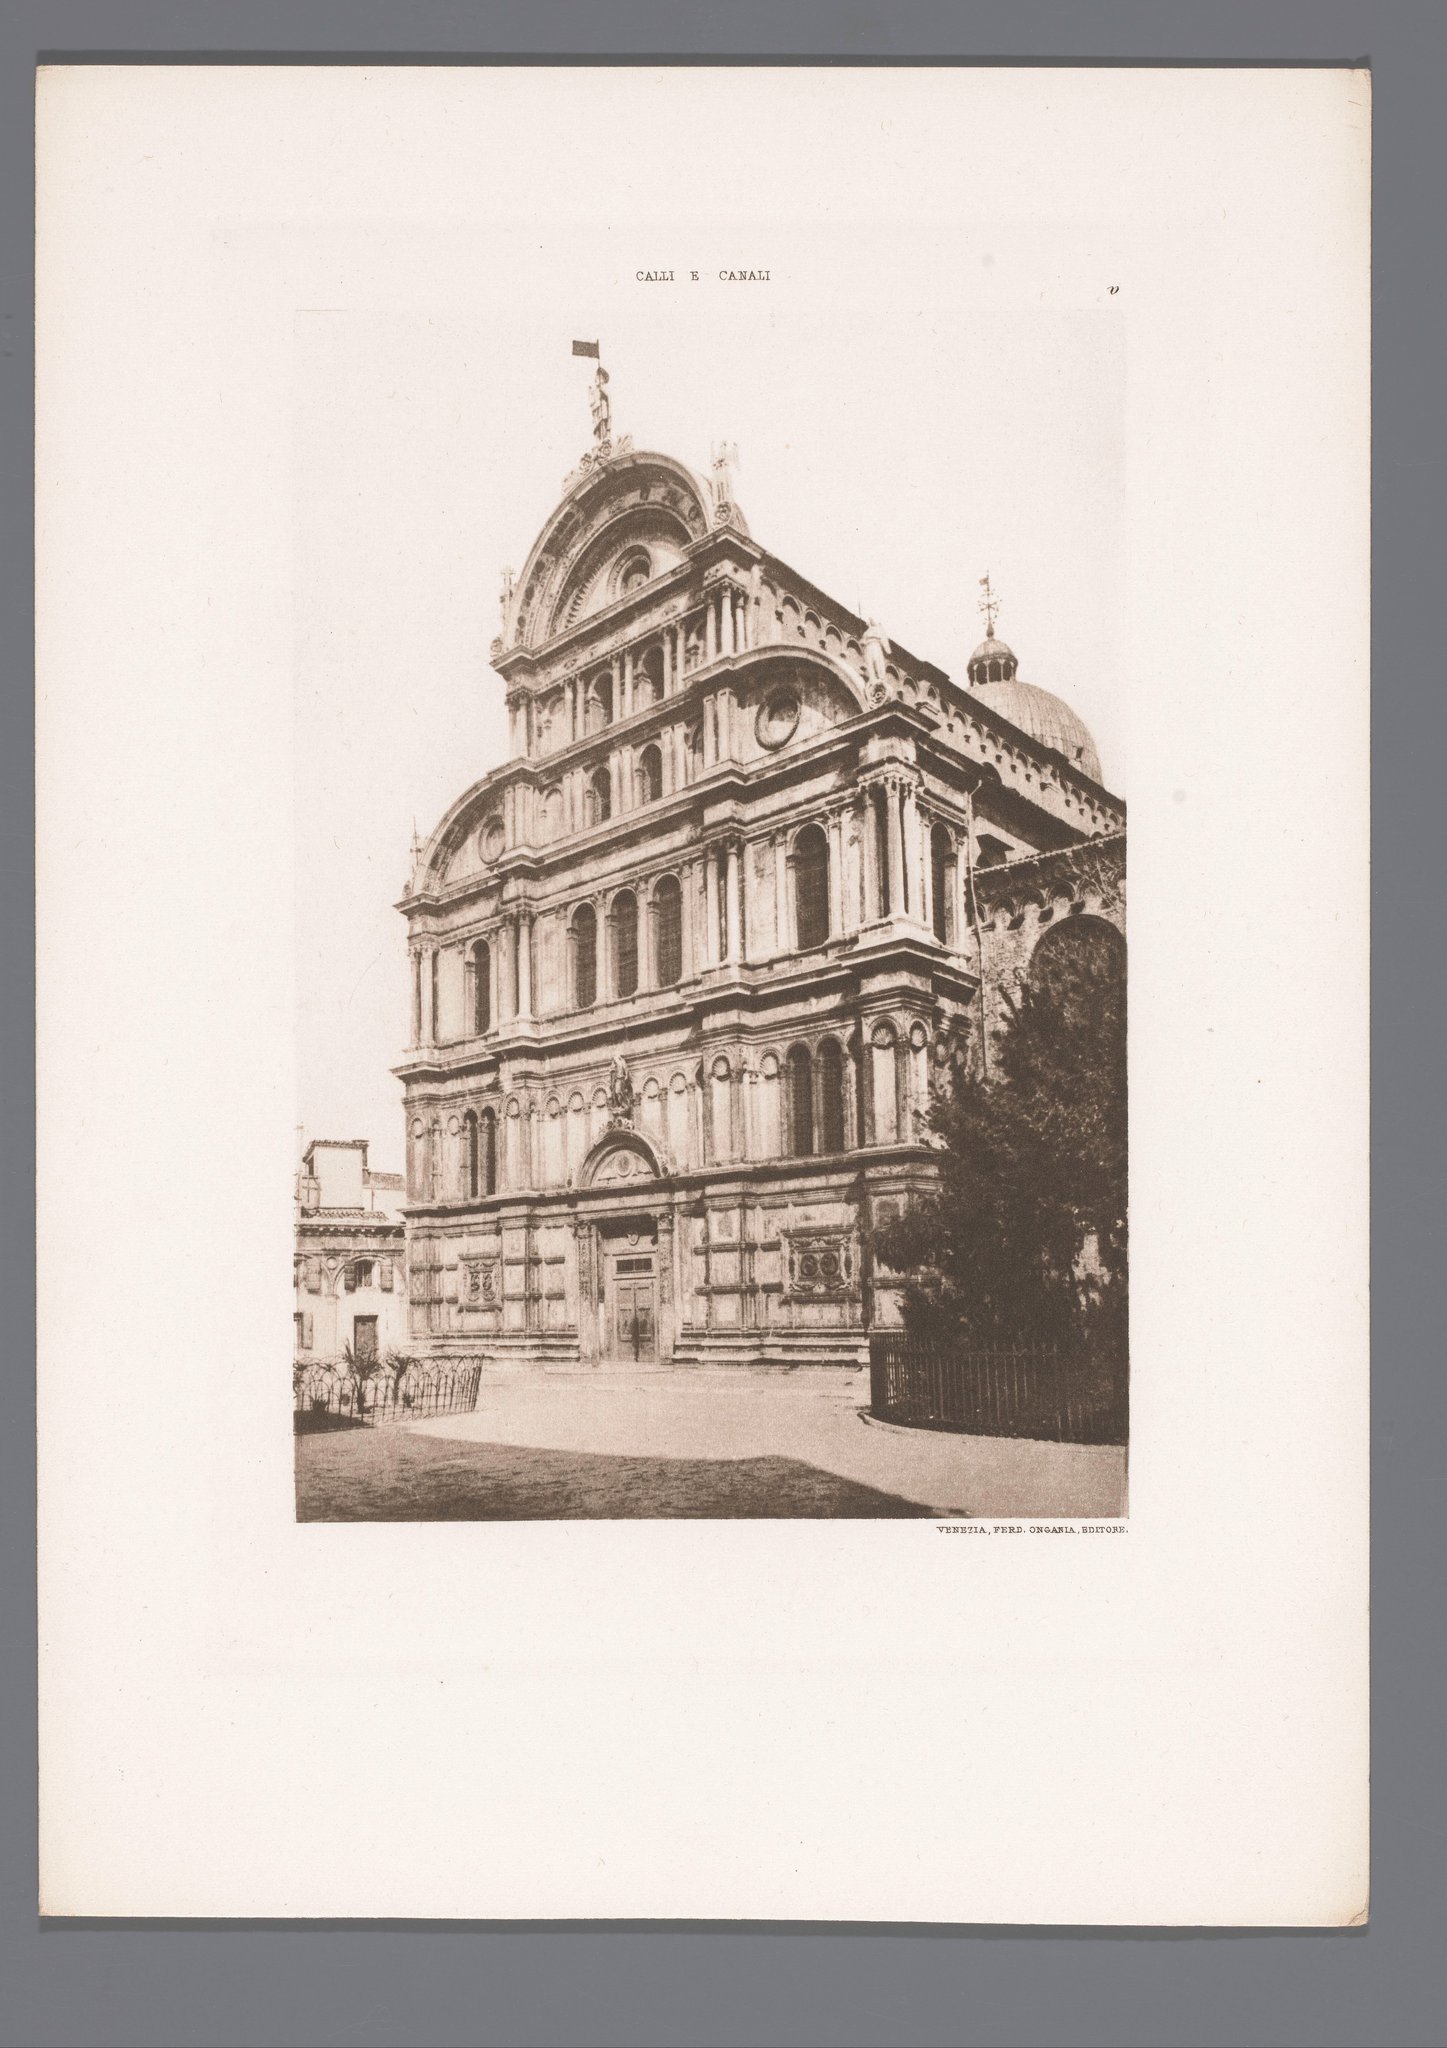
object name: page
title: Calli e canali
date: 1888-1898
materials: paper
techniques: photoaquatint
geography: venice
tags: parts of church exterior and annexes: façade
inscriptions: inscription: ‘v’